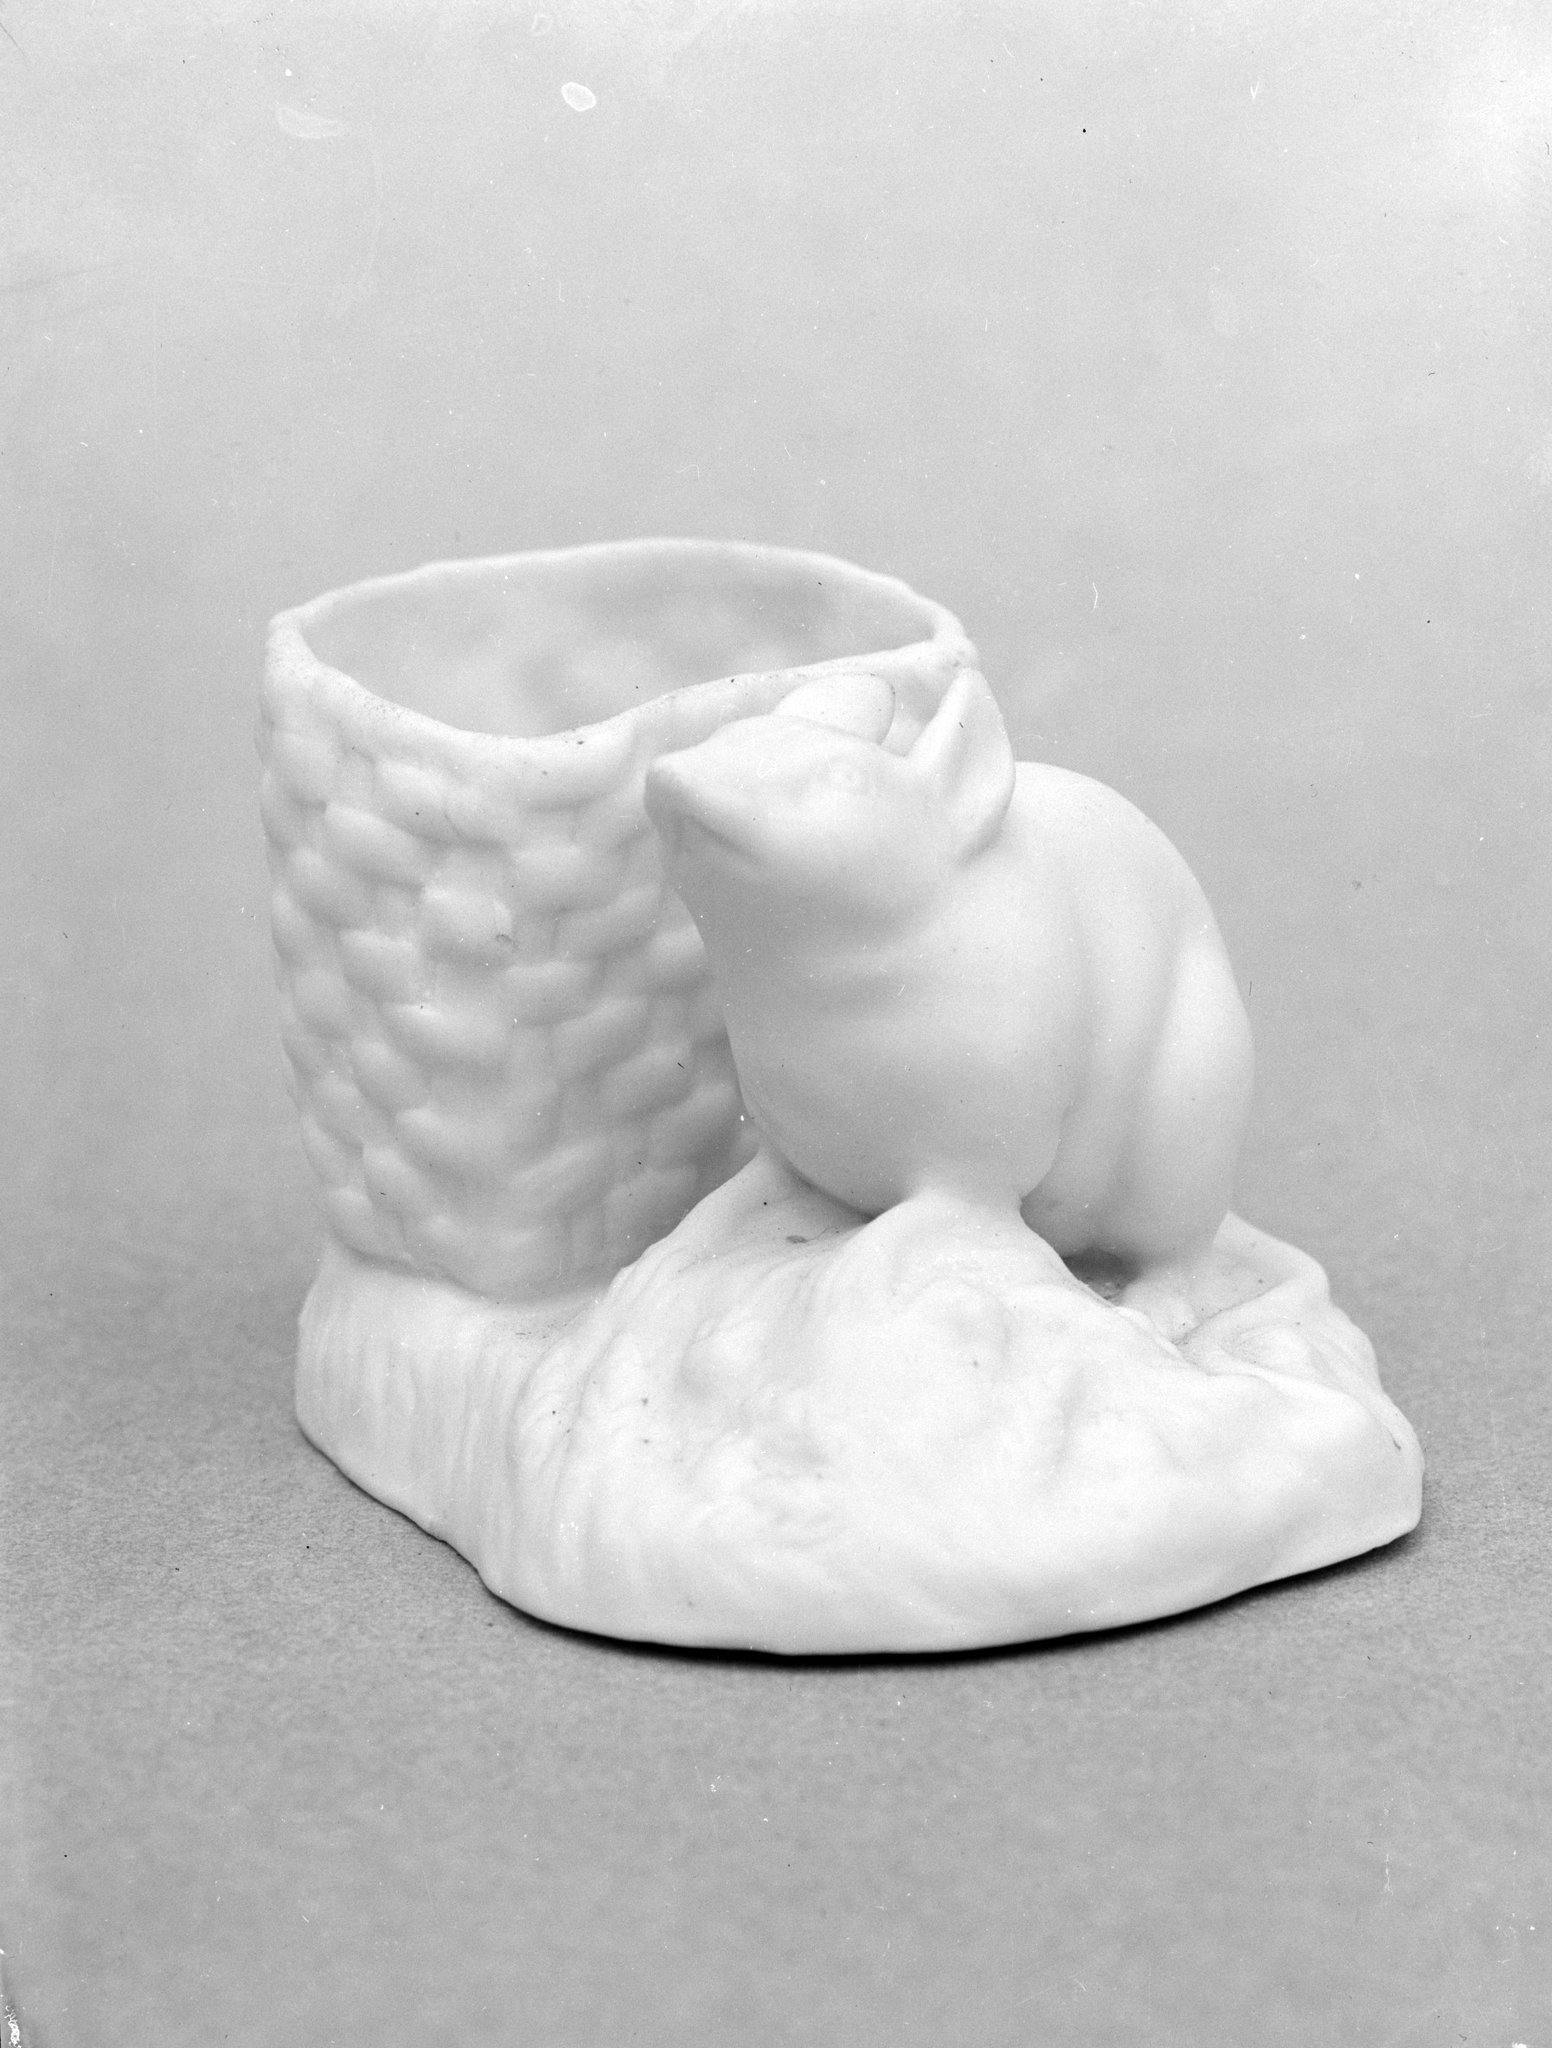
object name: matchsafe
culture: american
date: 1830-1870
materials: porcelain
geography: united states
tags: mice